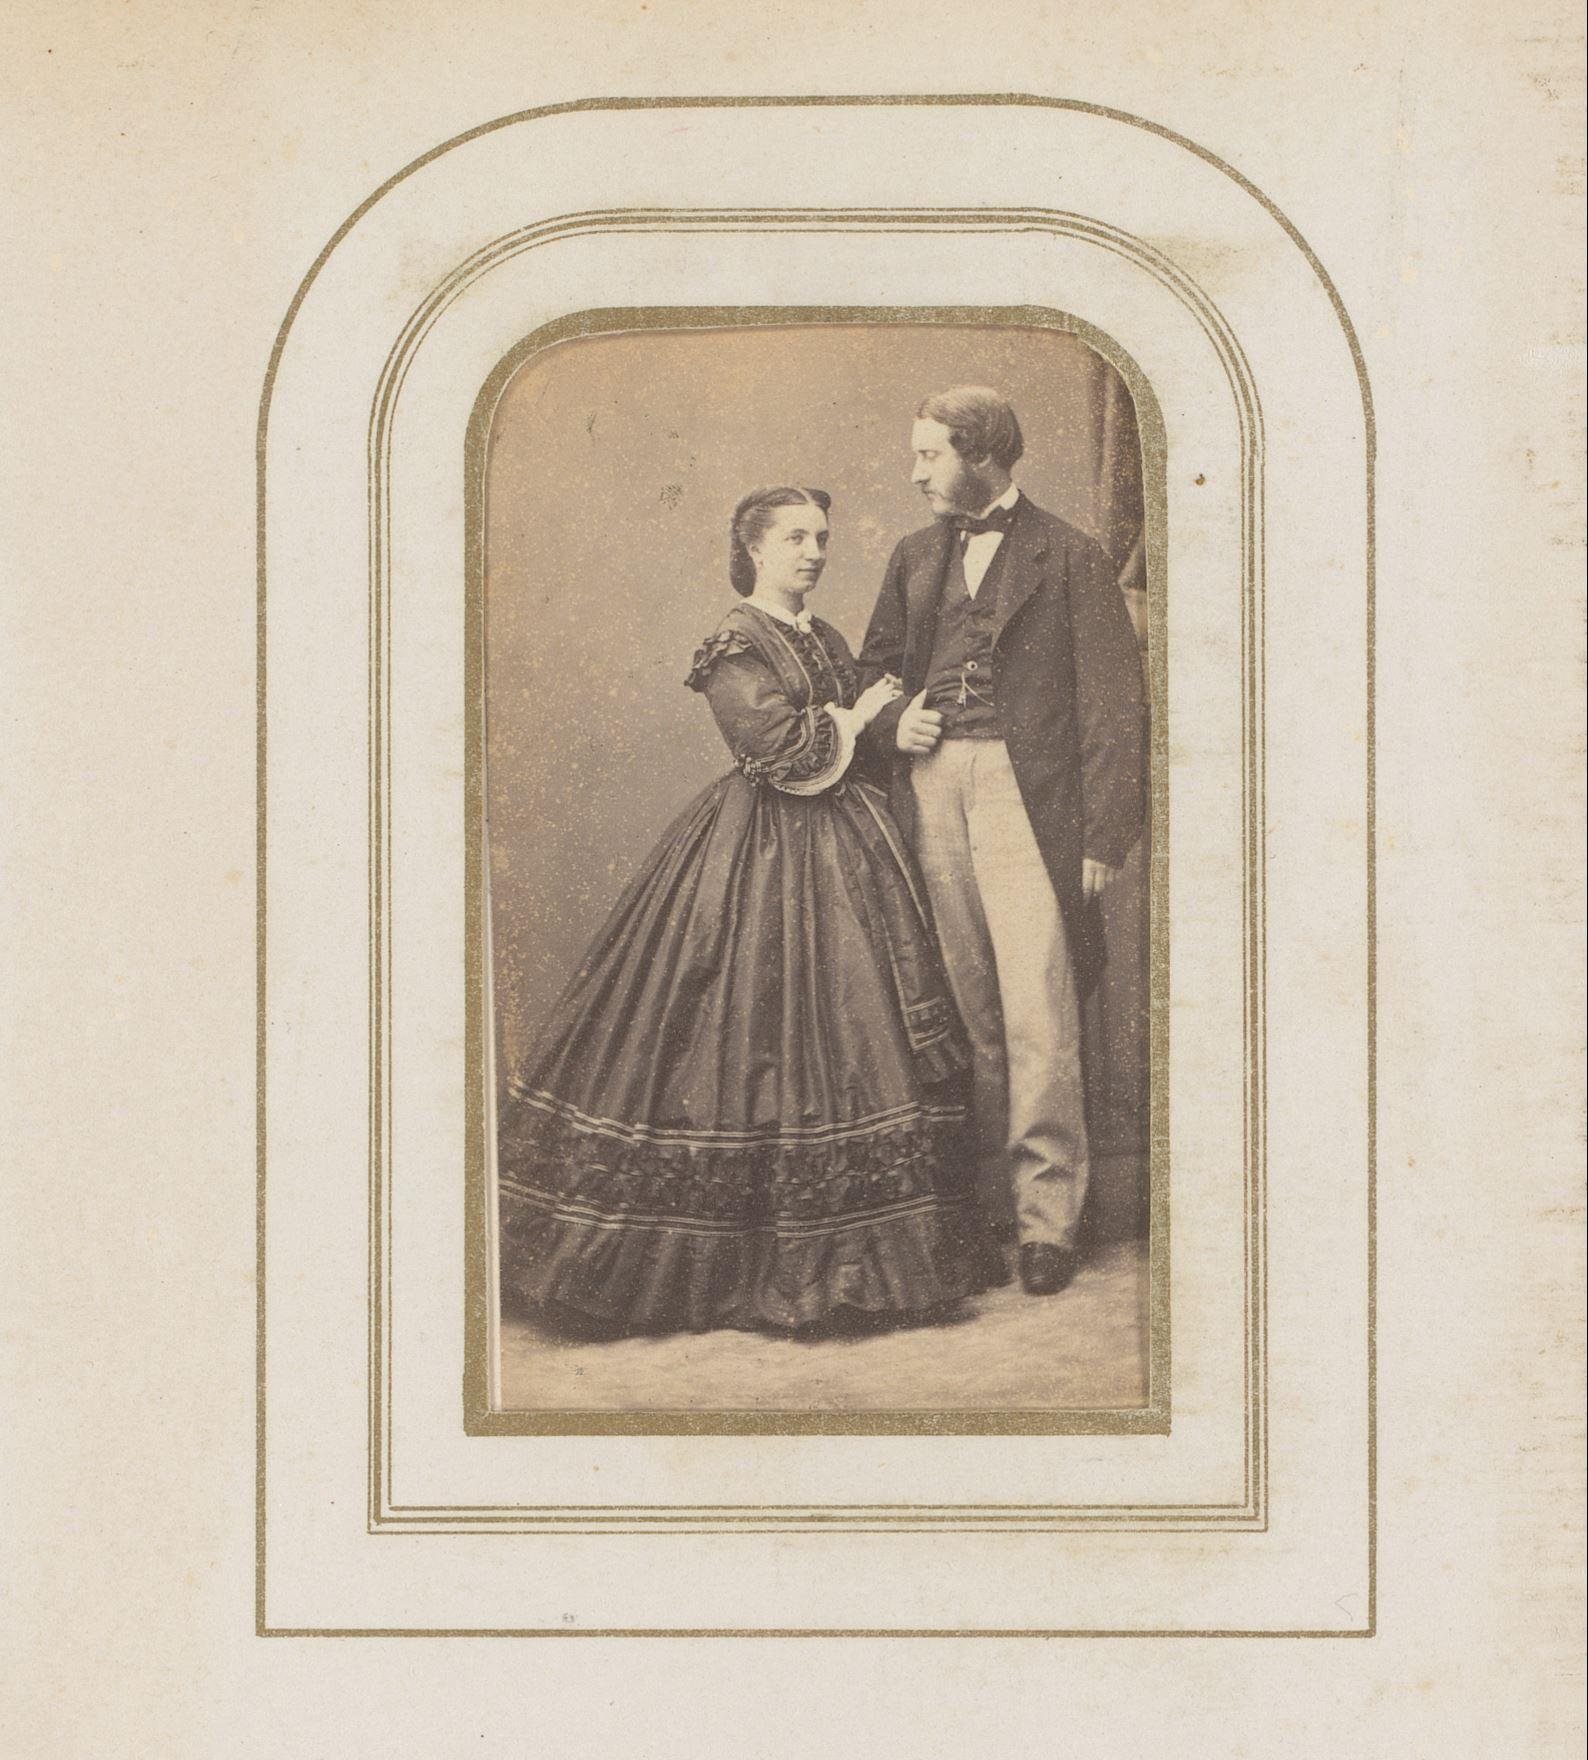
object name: photograph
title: Portret van een echtpaar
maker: edouard amédée carette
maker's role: fotograaf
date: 1860-1890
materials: cardboard, photographic support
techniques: albumen print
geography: lille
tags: historical persons - bb - woman, historical persons, couple of lovers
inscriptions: inscription: ‘Carette/ Photographe/ 9, Rue Esquernoise, 9/ Lille’